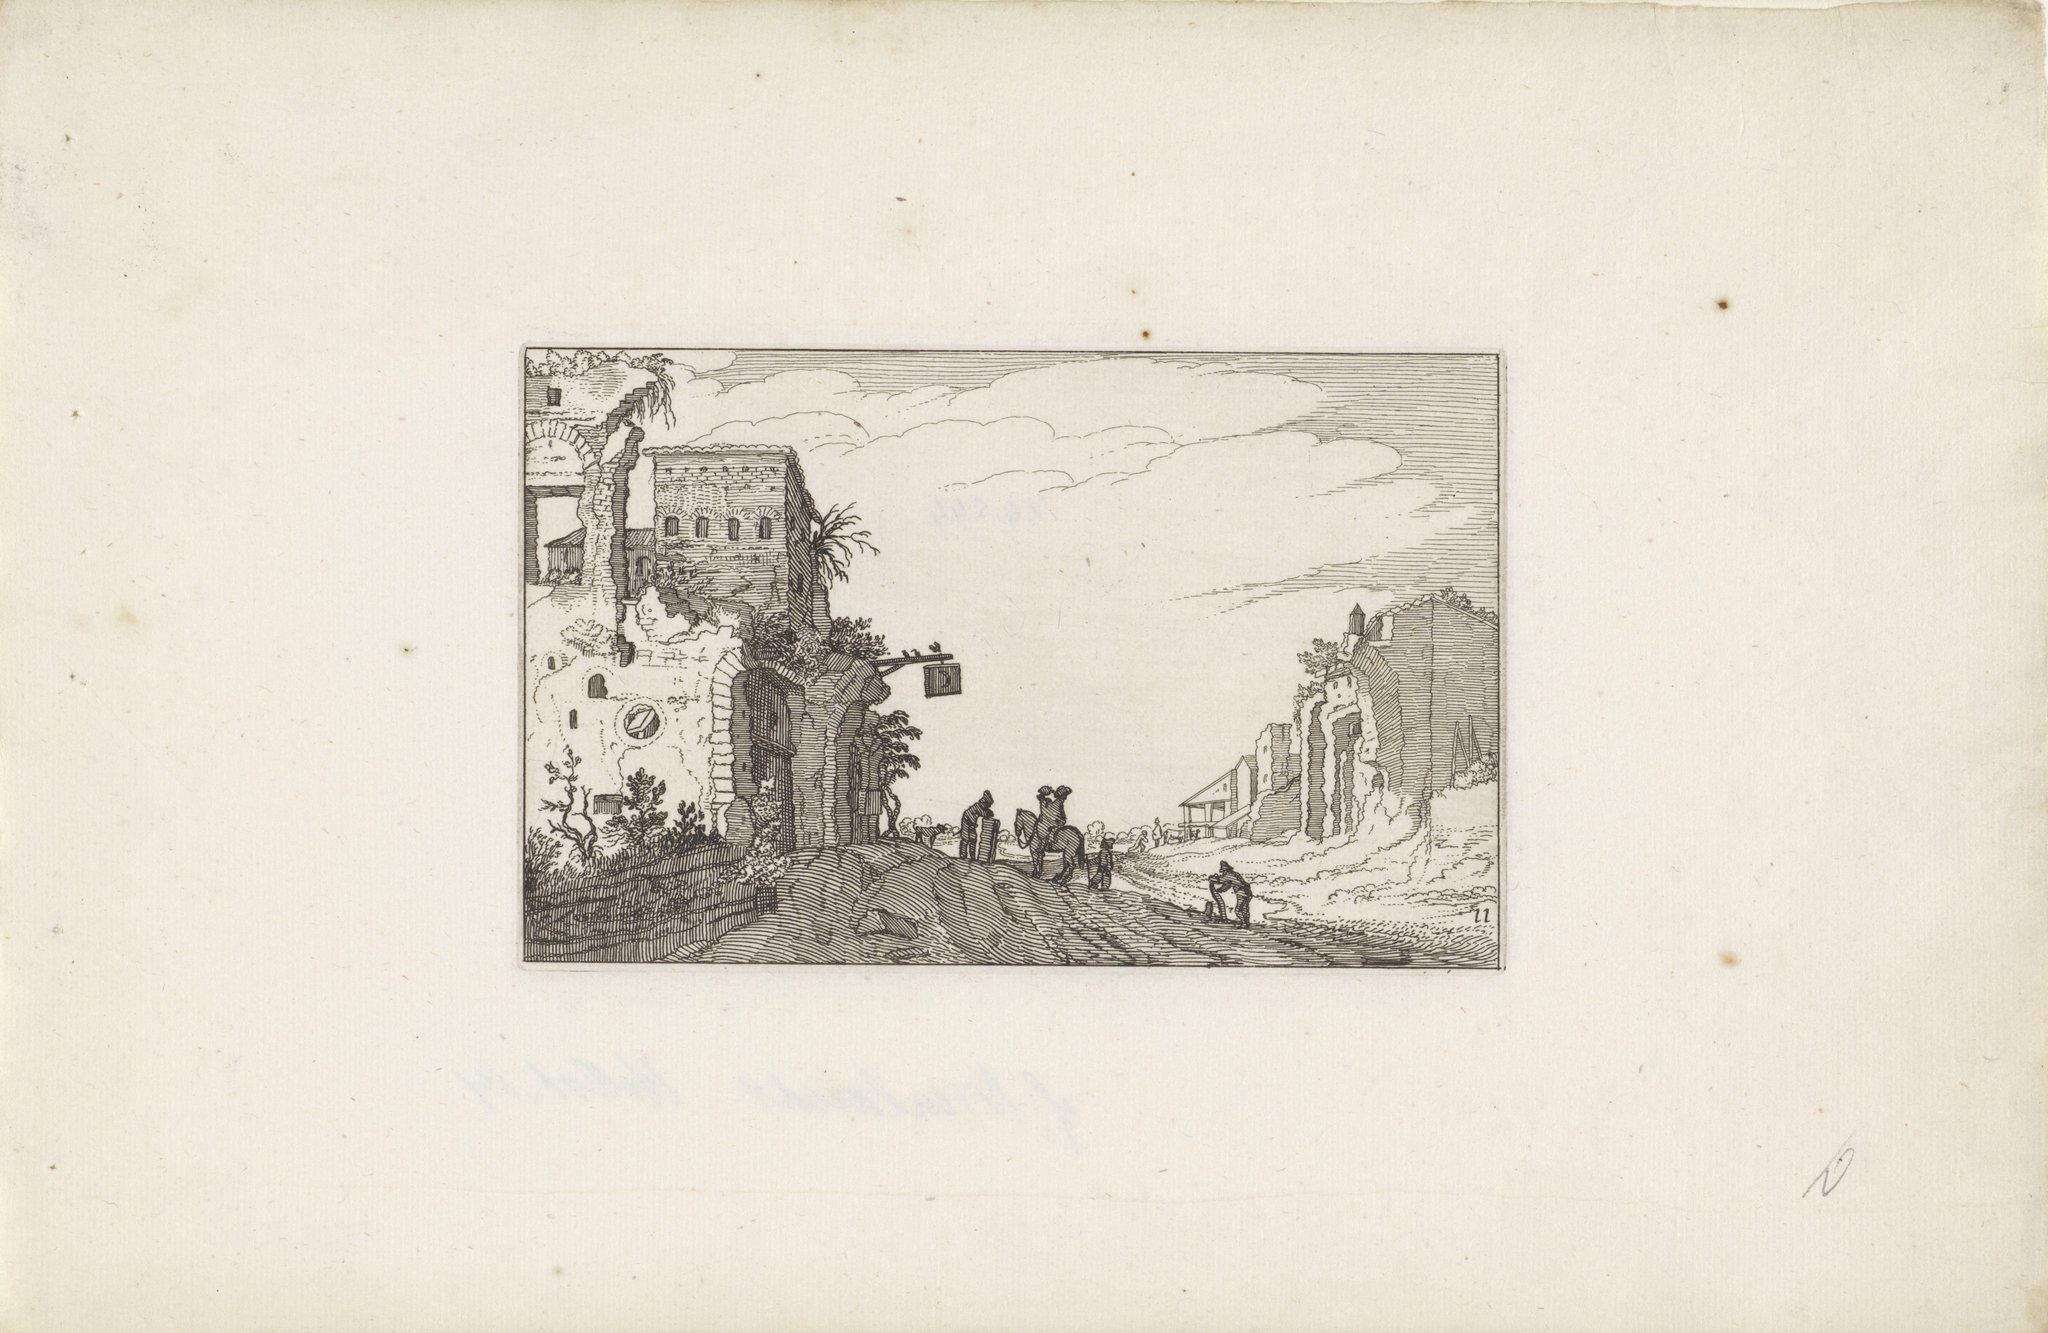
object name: print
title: Variae antiquitates Romanae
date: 1618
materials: paper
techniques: etching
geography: amsterdam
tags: inn, coffee-house, public house, etc., 'en route', traveller under way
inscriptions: collector's mark: Lugt 2233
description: Gezicht op een weg met aan weerszijden ruïneuze gebouwen. In een van de gebouwen is een herberg gevestigd, de vlag hangt uit. Voor de herberg staan enkele reizigers.